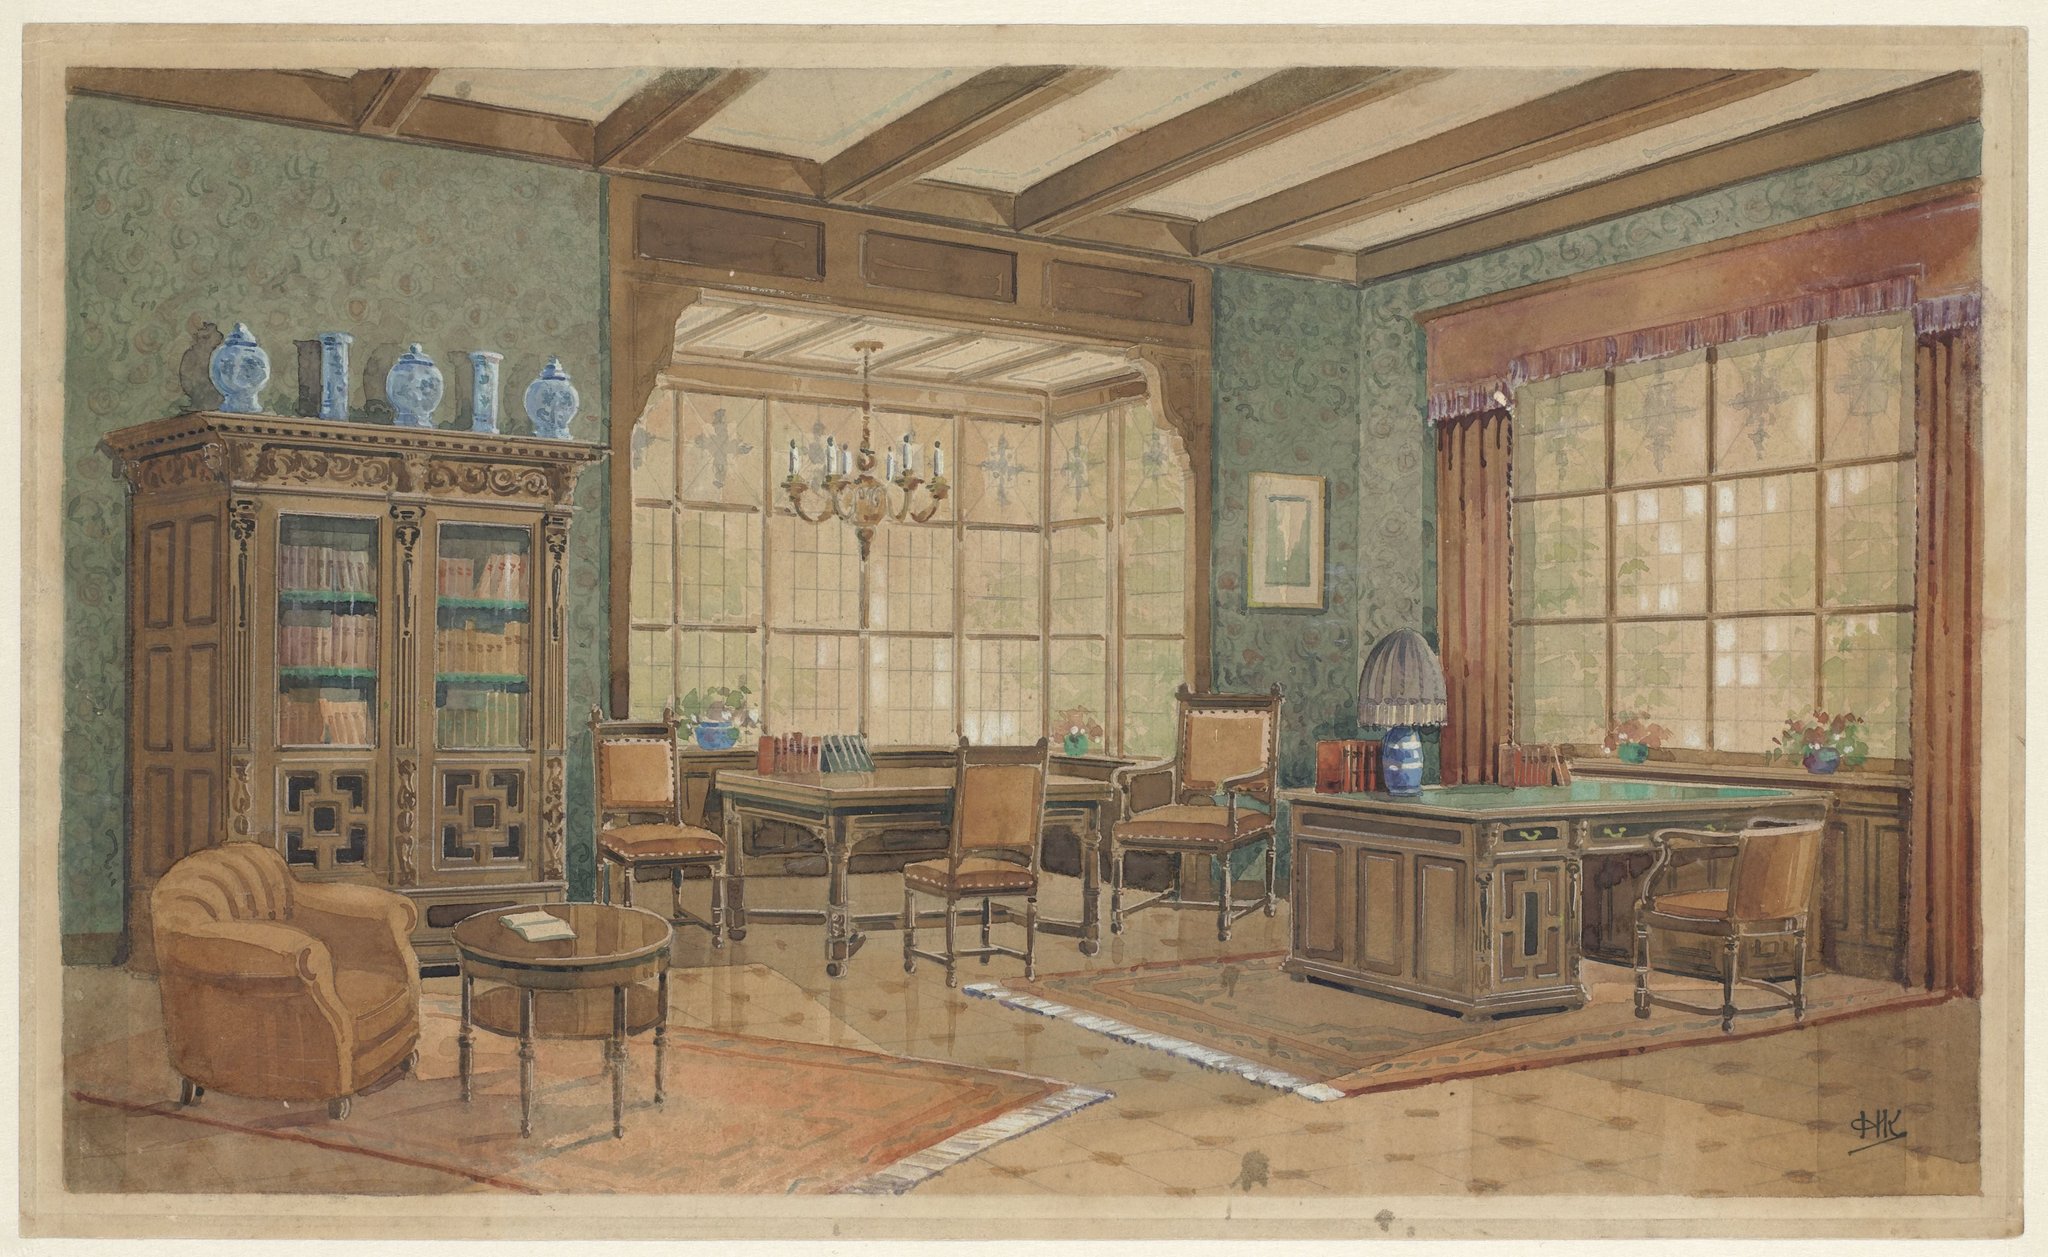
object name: drawing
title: Interieur met boekenkast in renaissance-stijl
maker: monogrammist hk (nederland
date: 1925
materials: paper, watercolor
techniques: brush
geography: amsterdam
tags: bookcase, with doors, study; 'studiolo'; library, communal rooms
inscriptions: monogram: ‘HK’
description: Mogelijk is dit een demonstratietekeningen van een meubel- of inrichtingszaak.